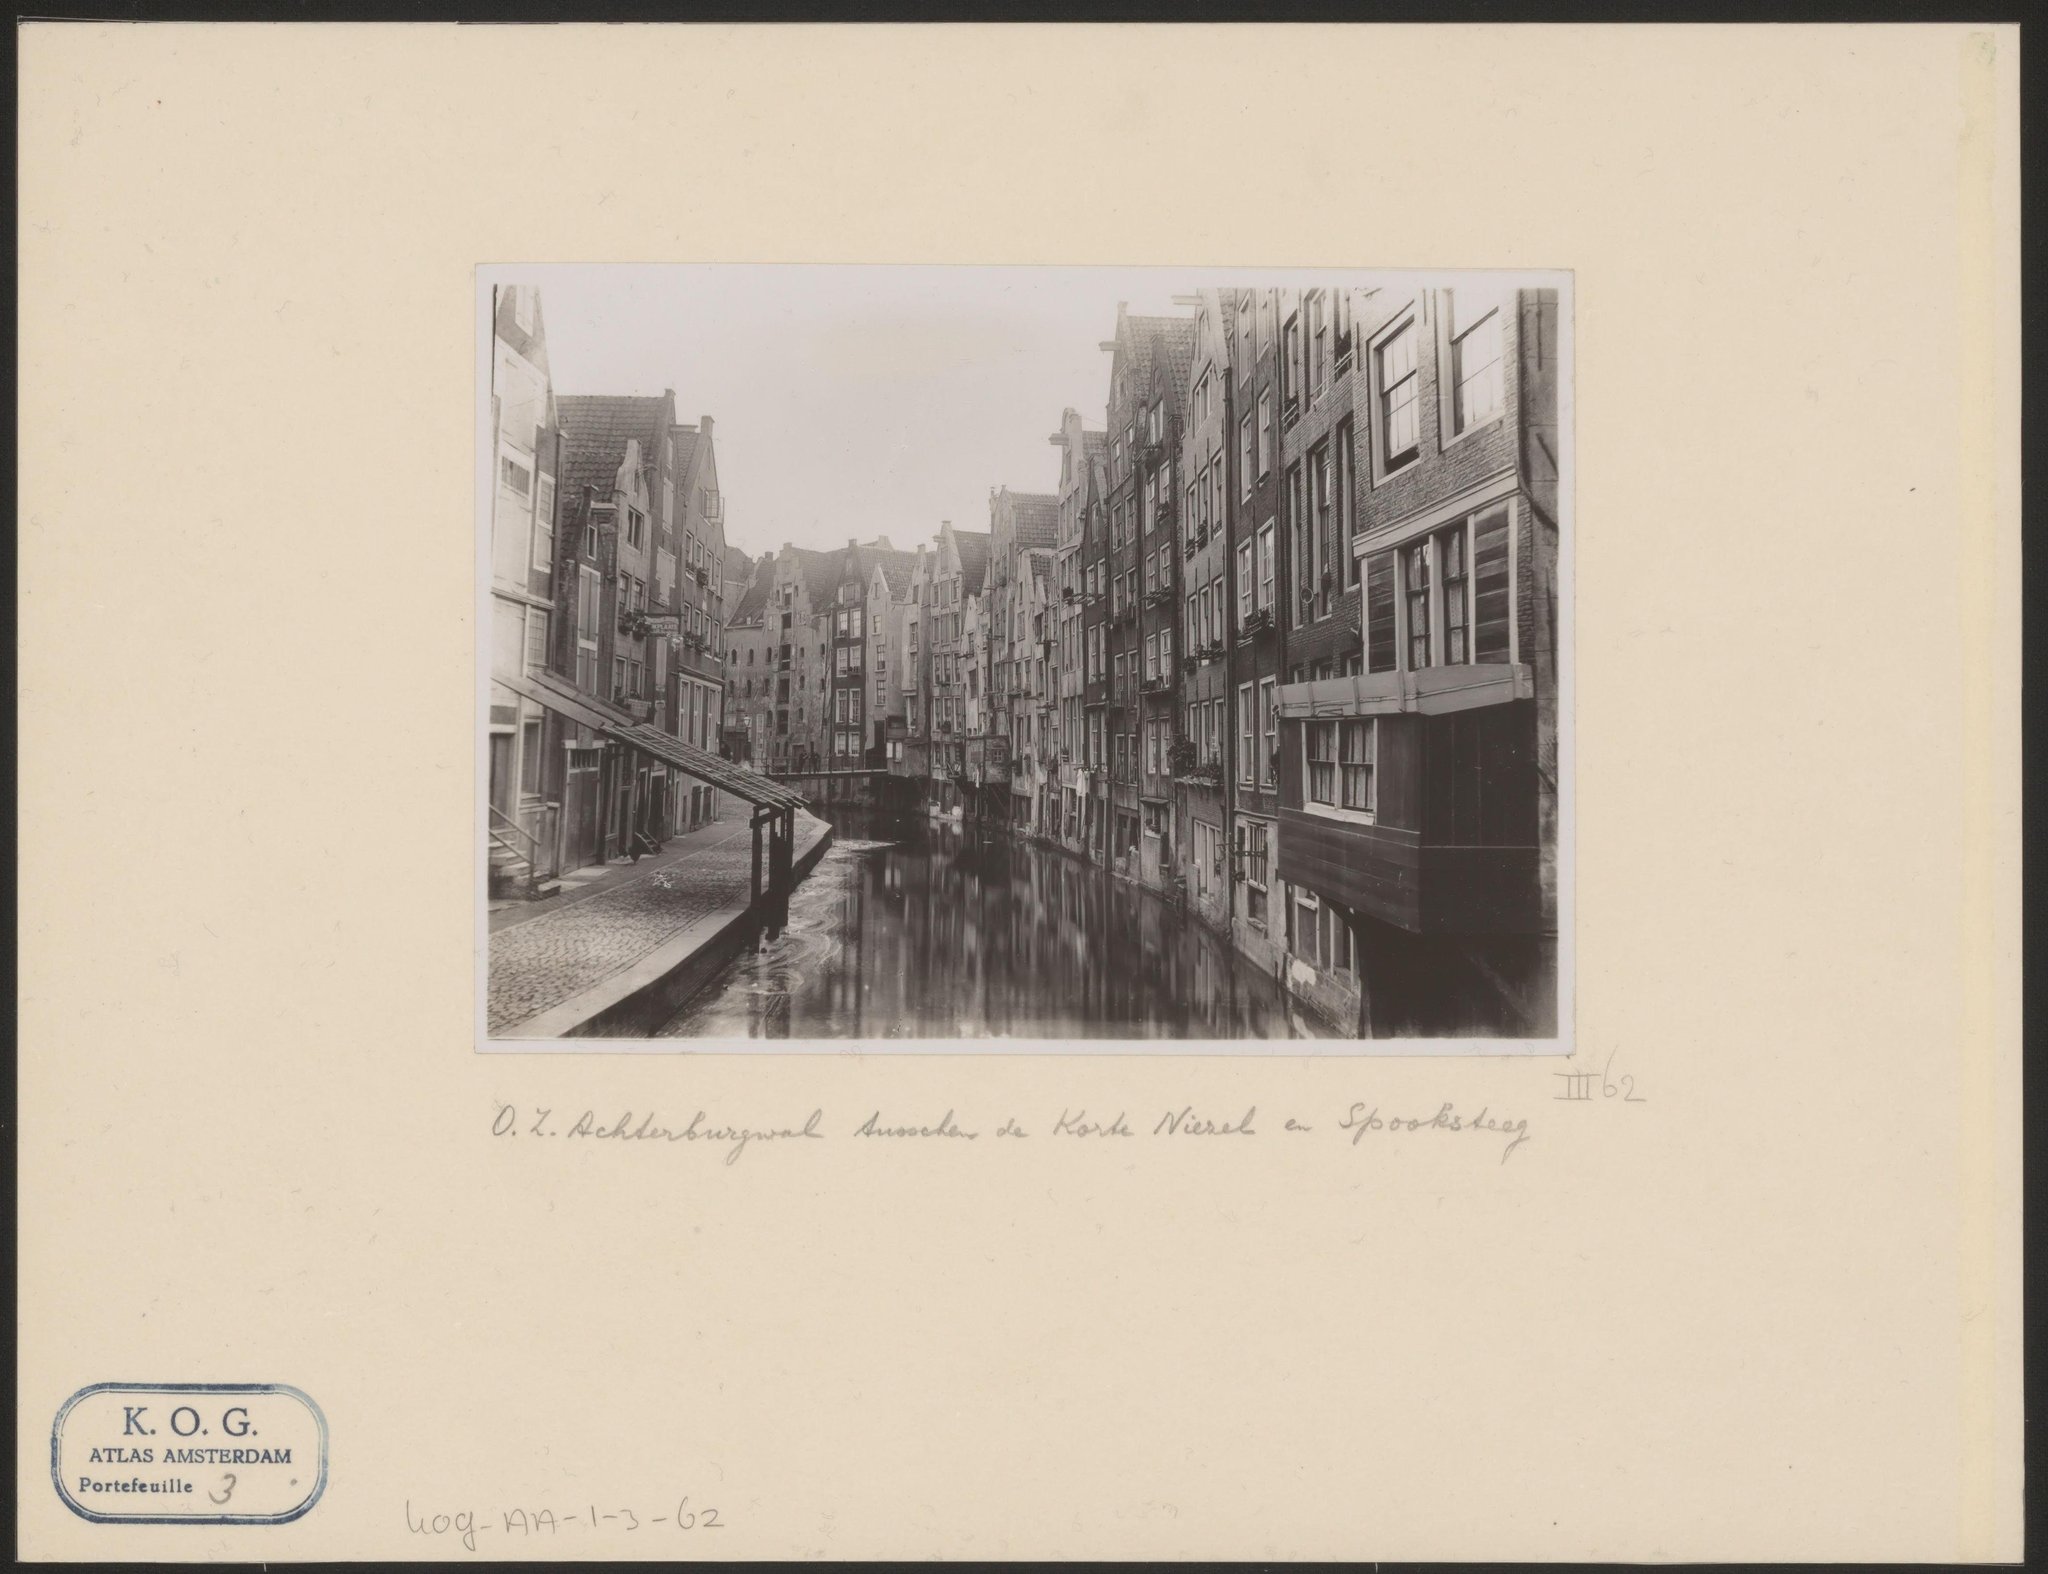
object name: photograph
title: Gezicht op de Oudezijds Achterburgwal tussen de Korte Niezel en de Spooksteeg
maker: Anonymous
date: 1880-1950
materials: paper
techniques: gelatin silver print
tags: city-view in general; 'veduta', canal, the usual house or row of houses, bridge in city across river, canal, etc.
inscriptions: collector's mark: ‘3’ Lugt 1641b, inscription: ‘O.Z. Achterburgwal tusschen de Korte Niezel en Spooksteef’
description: Onderwerpsrubriek binnen de Atlas Amsterdam: Achterburgwal, Nieuwezijds en - Oudezijds; Nieuwe Achtergracht, Achterweg, Akoleienstraat.